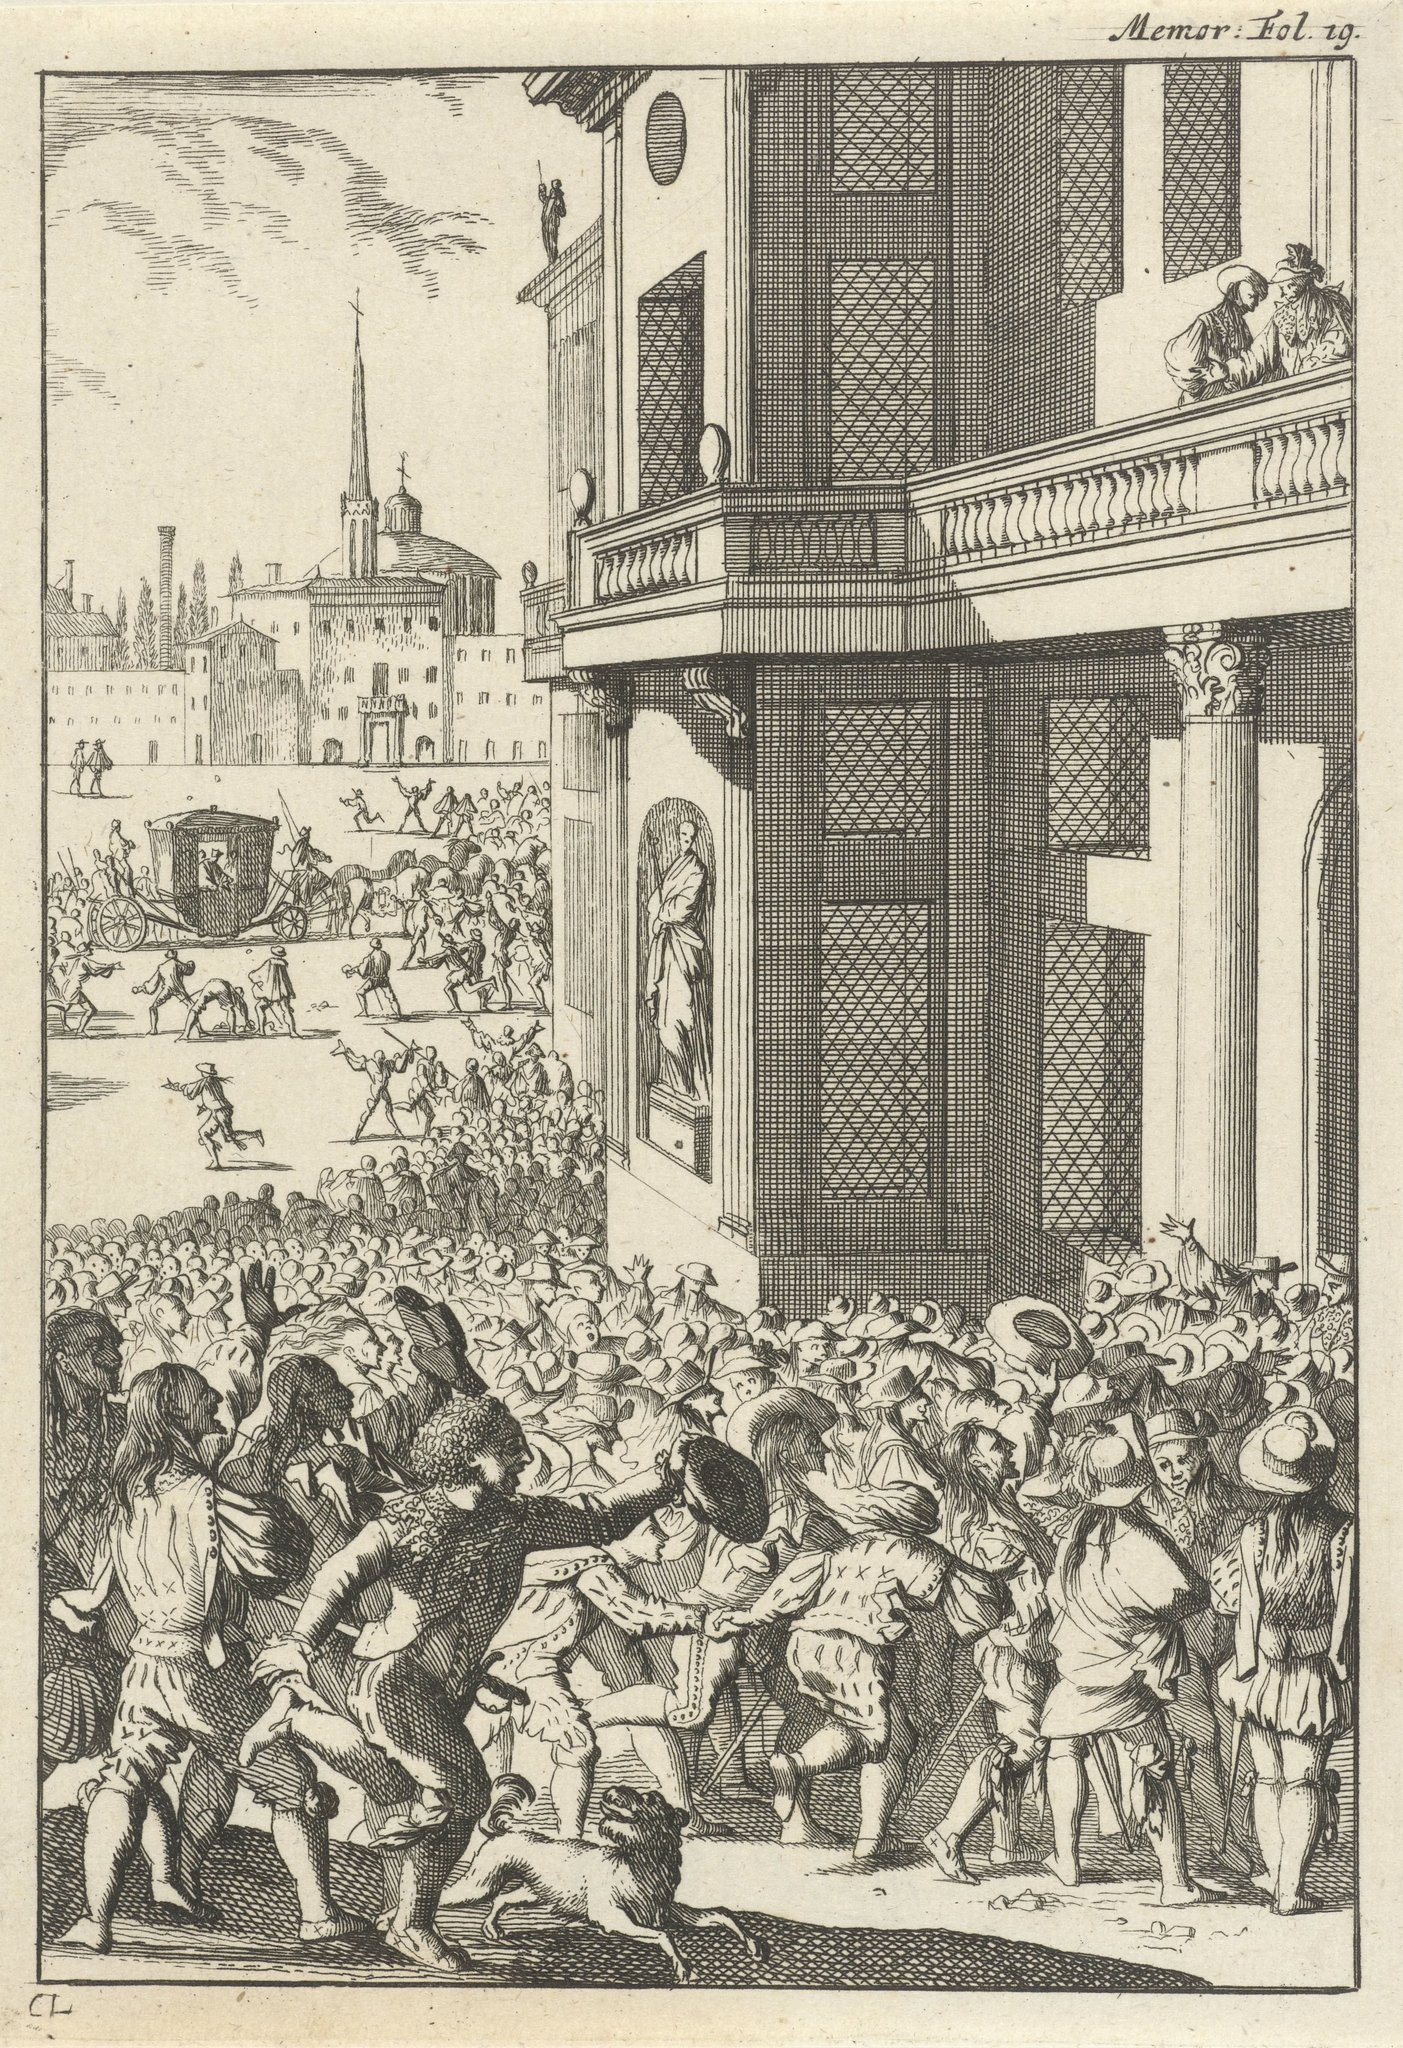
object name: print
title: Grote volksopstand voor het paleis te Madrid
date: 1696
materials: paper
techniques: etching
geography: amsterdam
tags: palace, revolution, revolt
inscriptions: collector's mark: Lugt 2228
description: Illustratie uit: D'Aulnoy, Marie Cathérine Le Jumel de Barneville. Reyse door Spaignien, neffens memorien van des selfs hofs. Utrecht: Willem Broedelet, 1696.